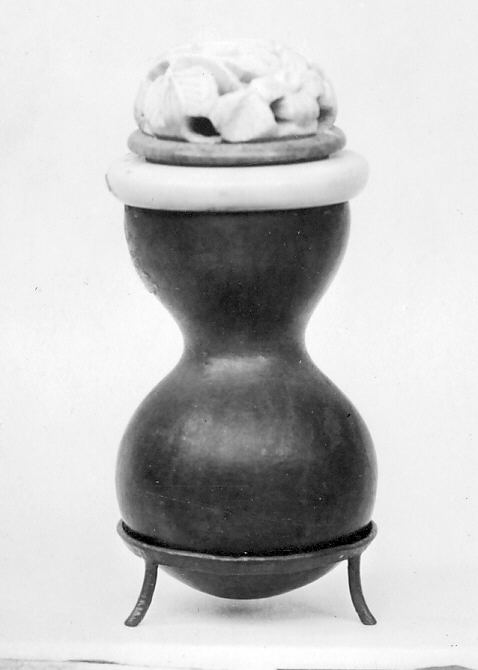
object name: cricket cage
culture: chinese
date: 1701-1900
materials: ivory